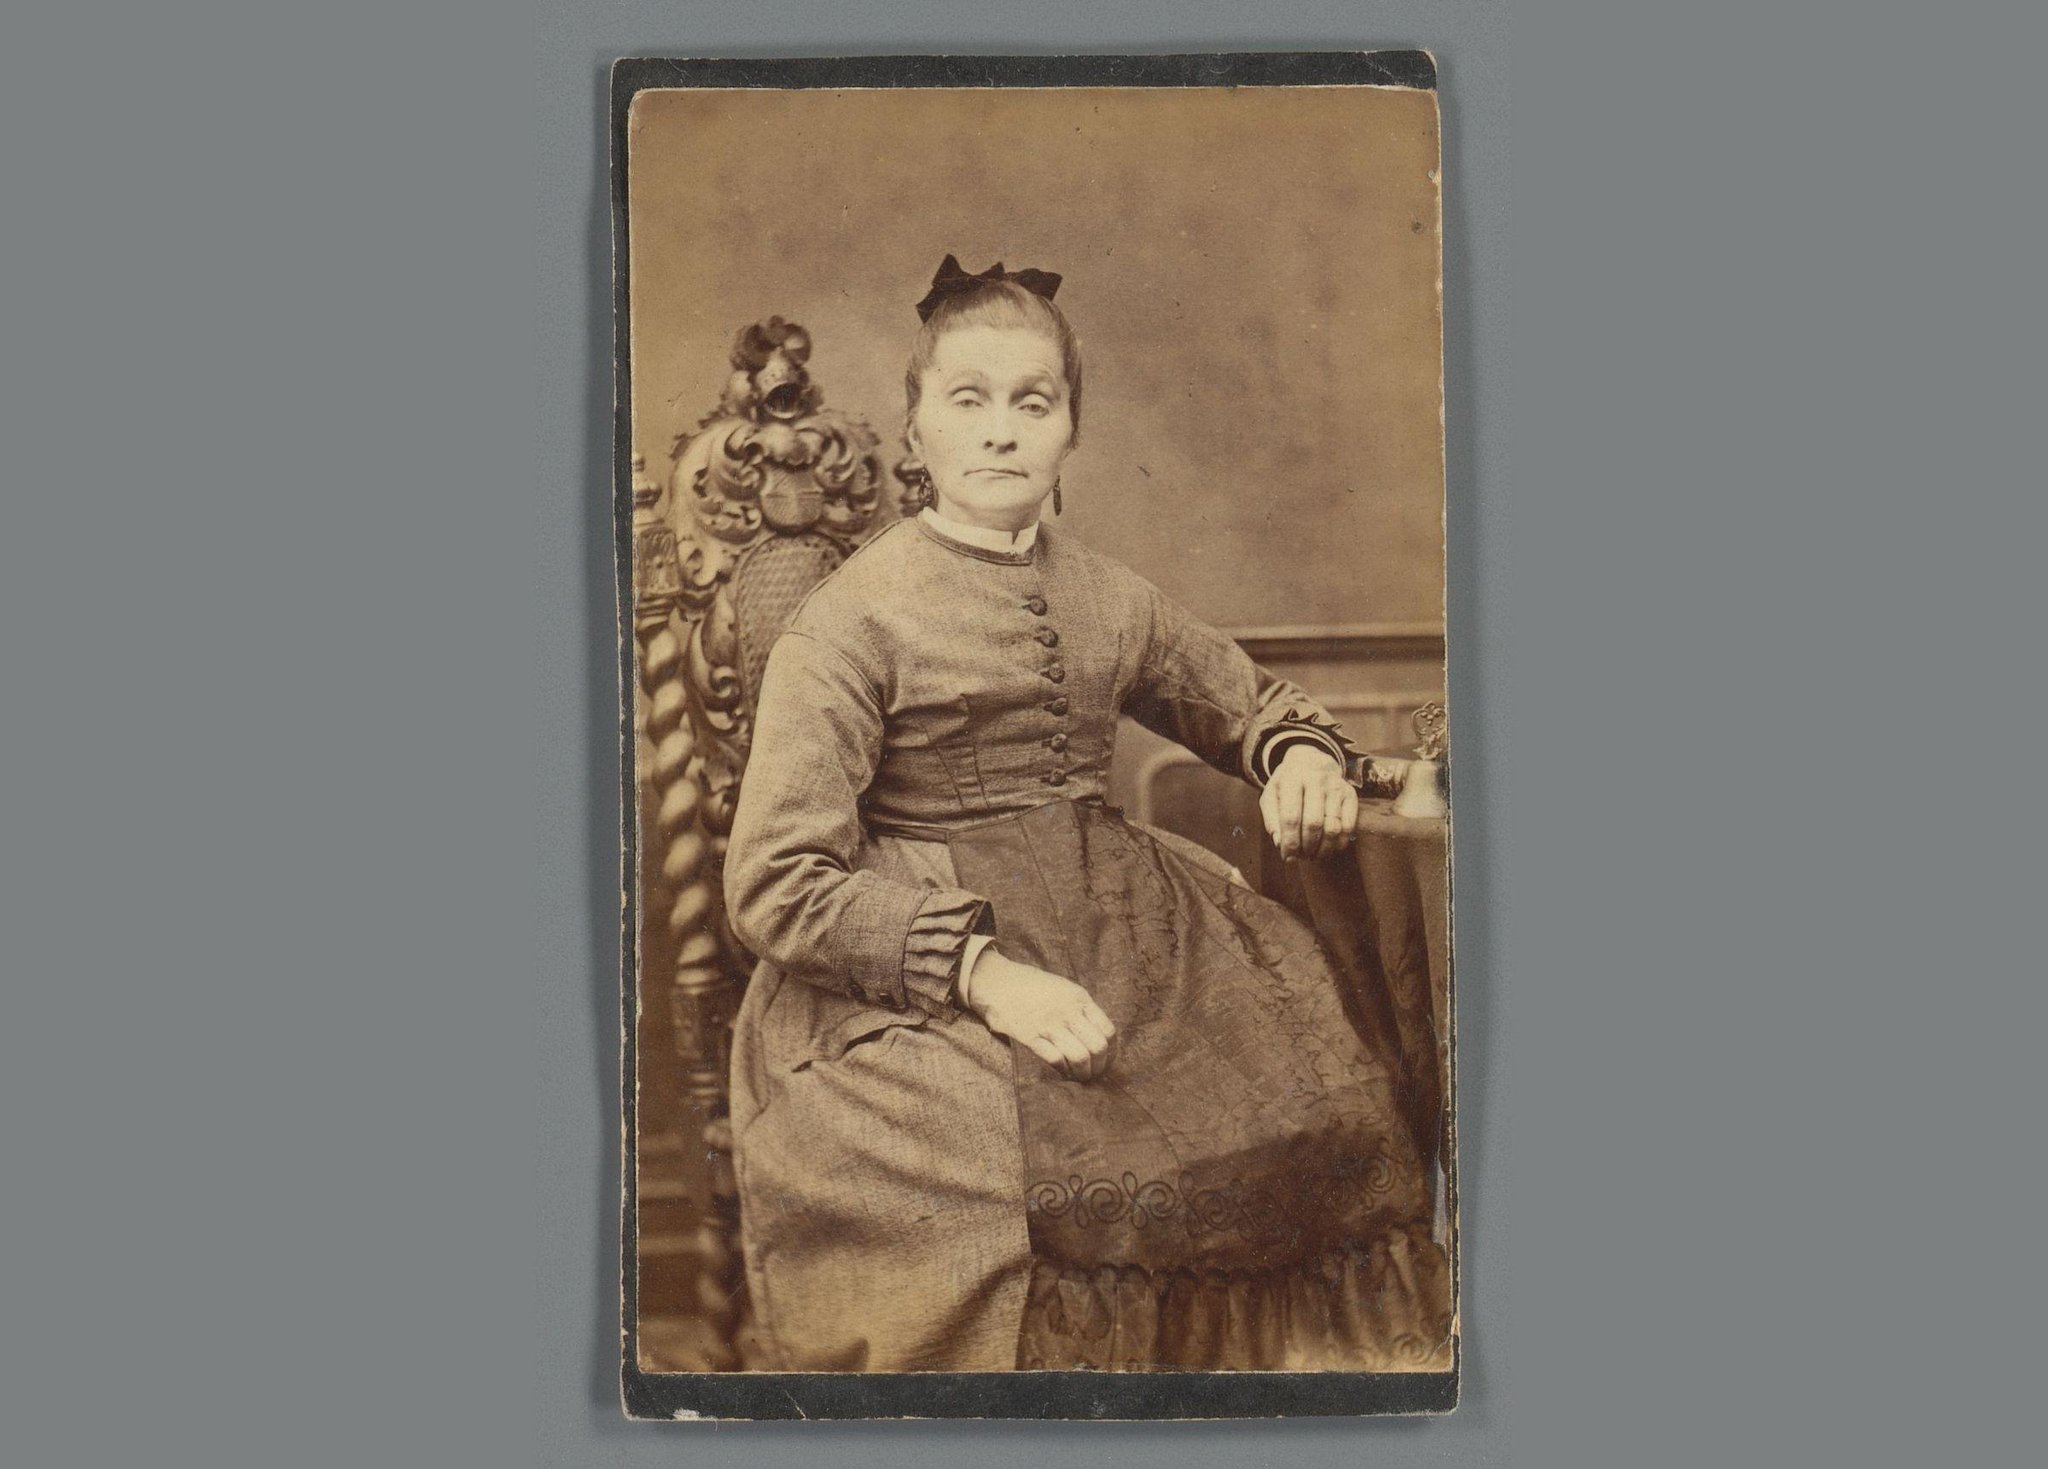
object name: photograph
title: Portret van Anna Scheuer op bidprent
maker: Anonymous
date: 1880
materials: paper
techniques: albumen print, letterpress printing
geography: delft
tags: delft, adult woman, historical persons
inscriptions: inscription: ‘Bid voor de ziel van zaliger (...) Onze Vader. - Wees gegroet.’